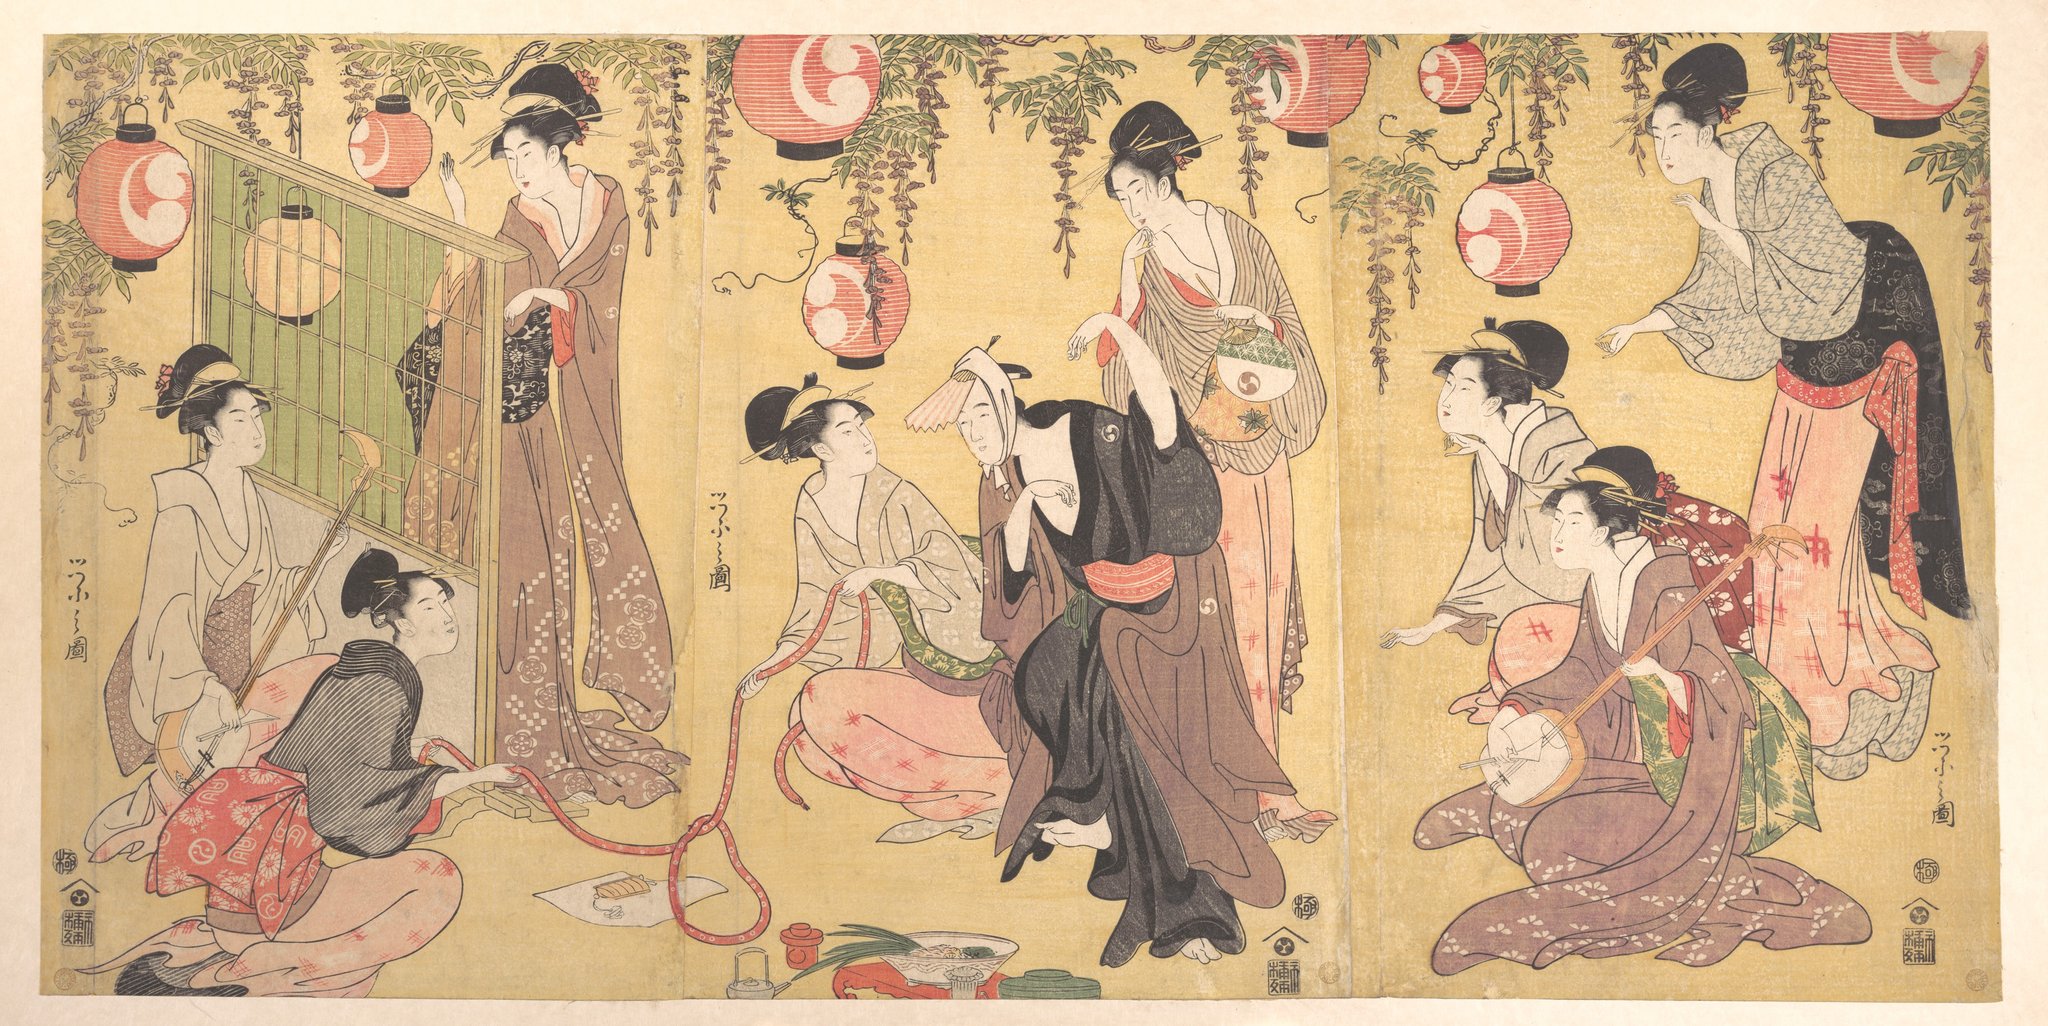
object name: print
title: A Parody of Yuranosuke in the Pleasure Quarters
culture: japanese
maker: chōbunsai eishi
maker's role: artist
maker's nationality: japanese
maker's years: 1756-1829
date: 1797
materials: ink, paper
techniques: woodblock print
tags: men,women